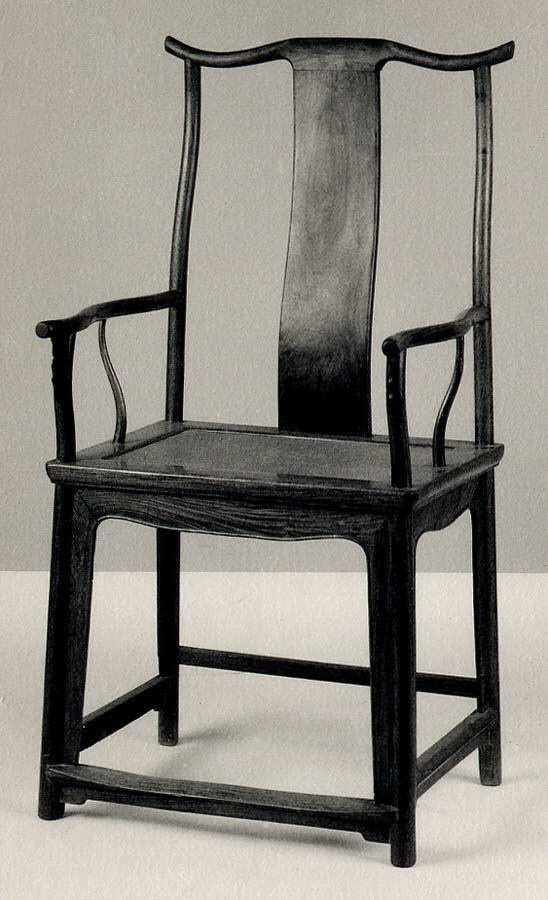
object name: armchair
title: Armchair (One of a Pair)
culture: chinese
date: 1700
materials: wood